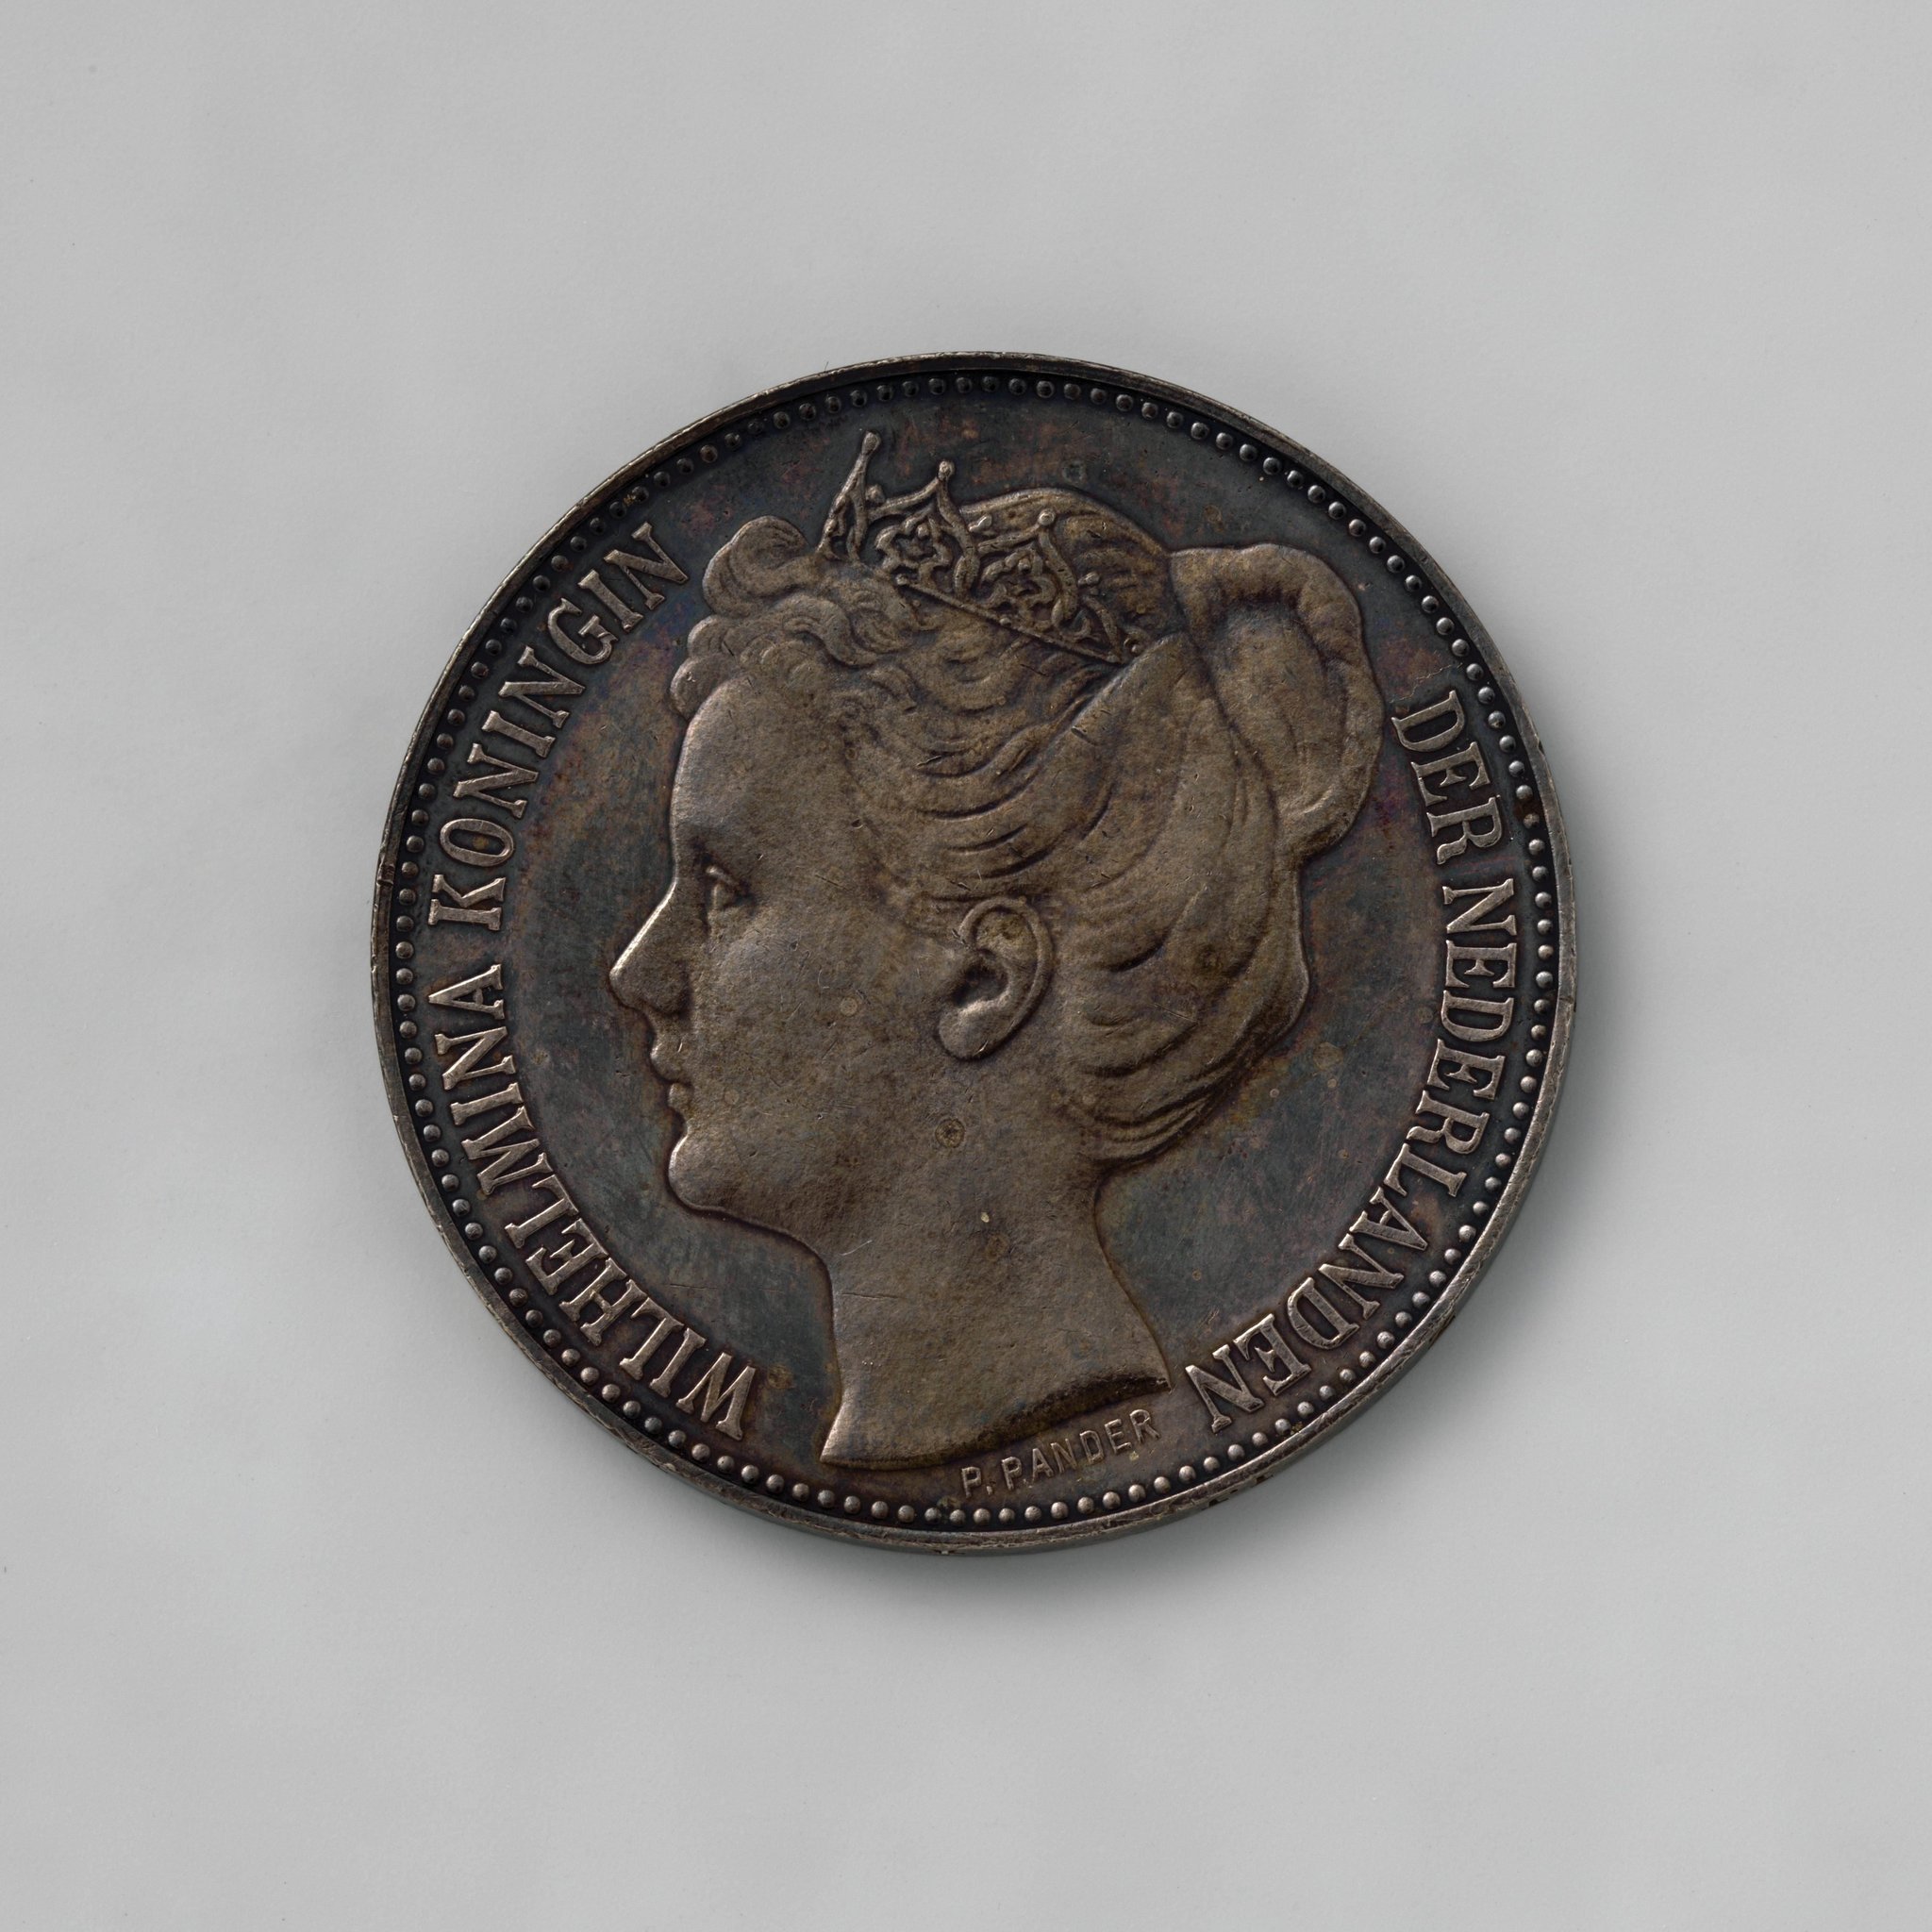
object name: coin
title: Nederlandse 2½ gulden, 1898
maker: wilhelmina of the netherlands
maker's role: print maker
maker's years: 1880-1962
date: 1898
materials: silver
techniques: striking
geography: utrecht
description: Zilveren munt. Voorzijde: hoofd met diadeem naar links.Keerzijde: tussen waarde-aanduiding 2½ G gekroond rijkswapenschild. Jaartal bovenaan in omschrift. Randschrift.